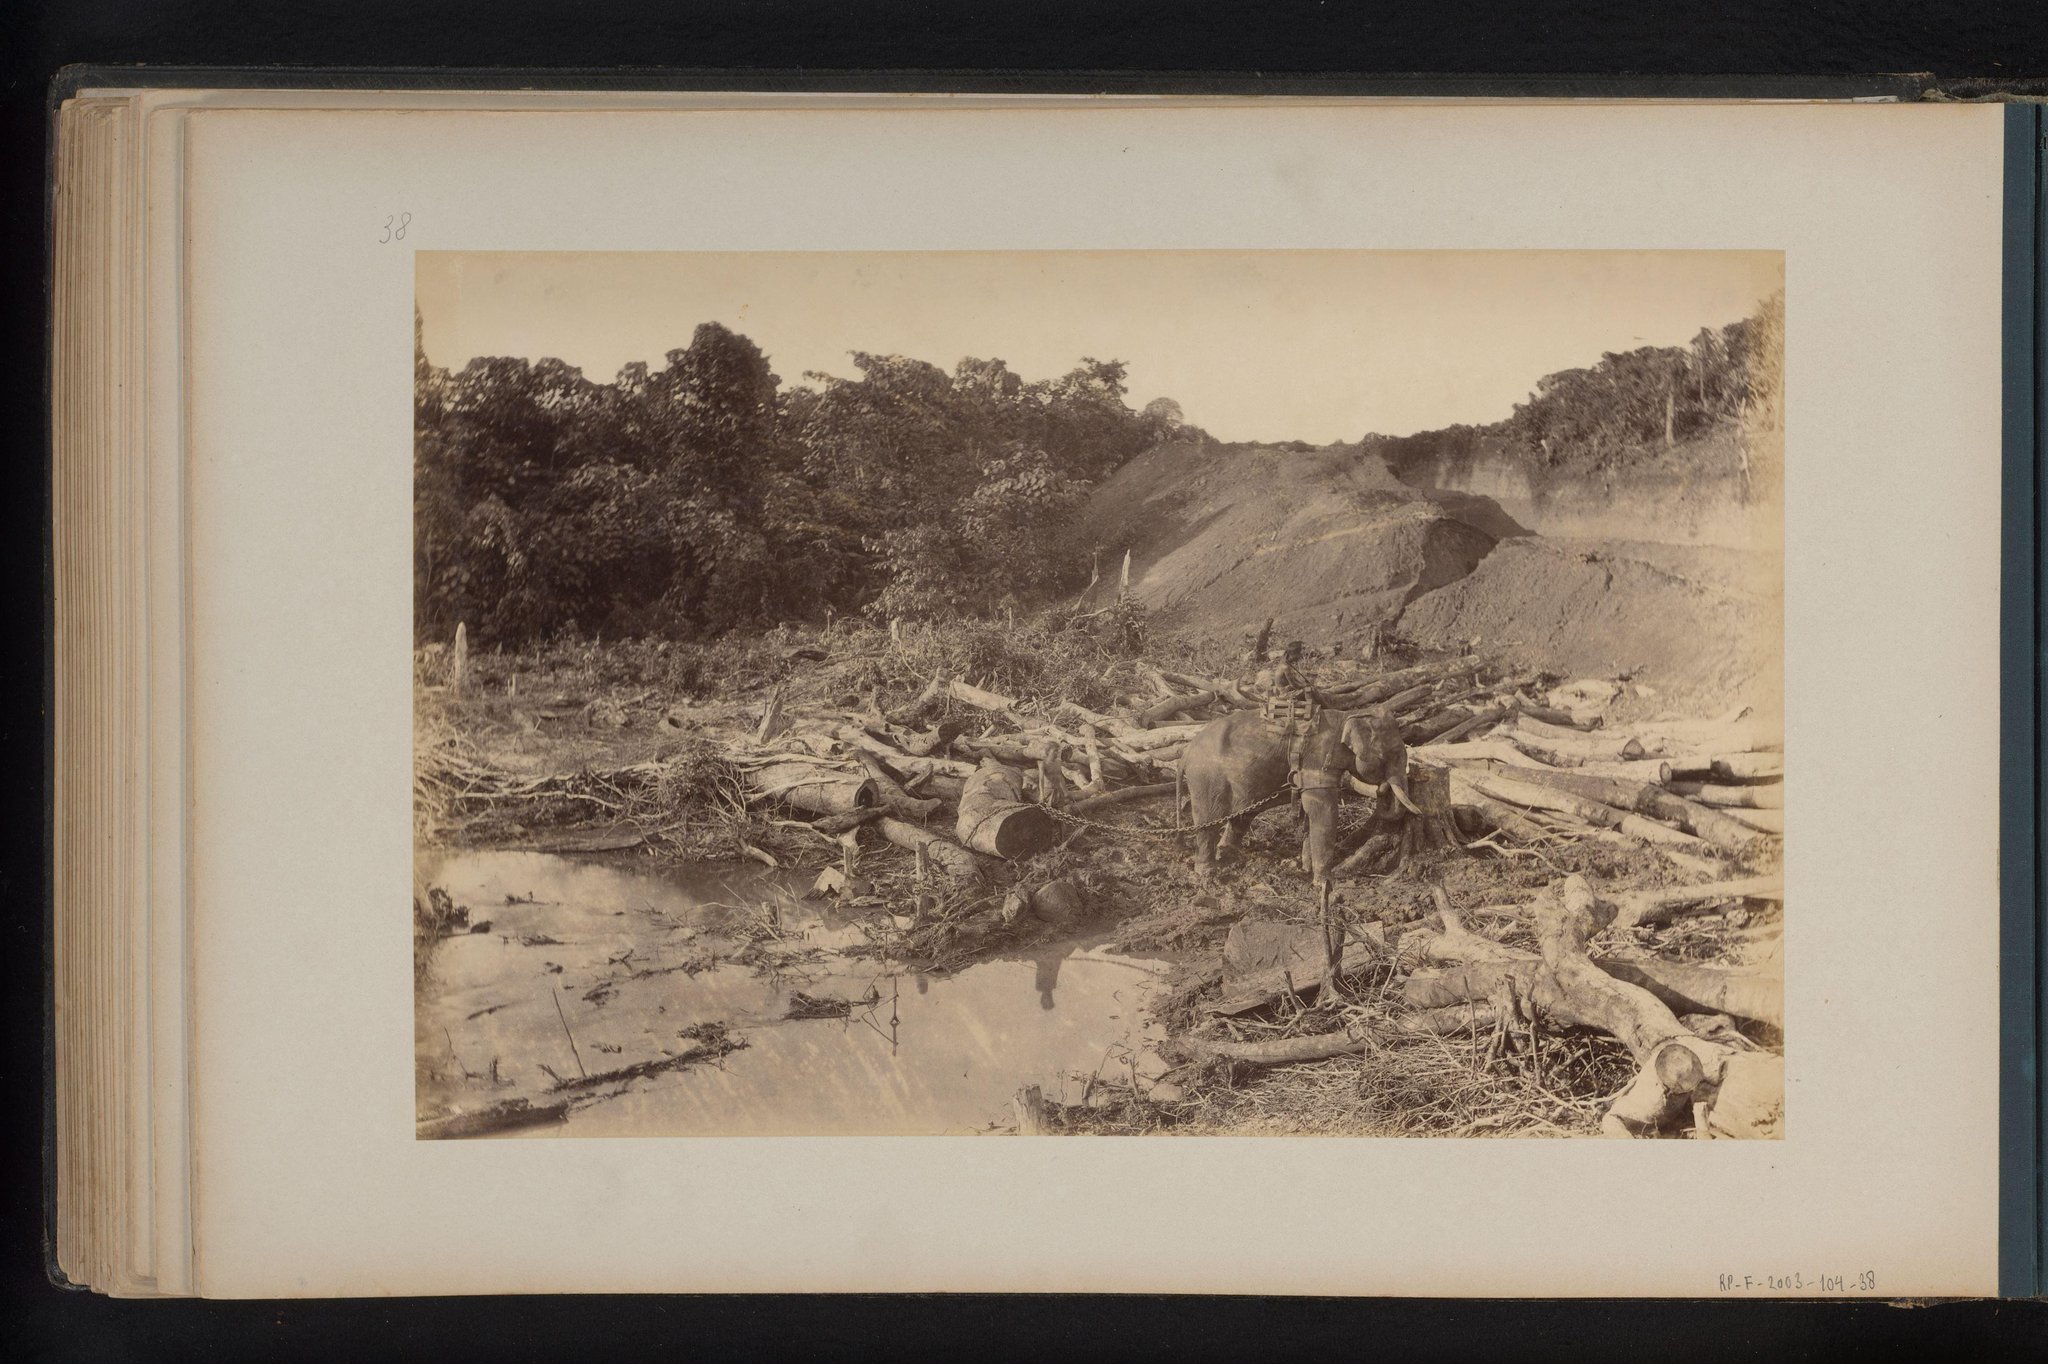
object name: album leaf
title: Arbeider op een olifant versleept boomstammen in een stuk gekapt oerwoud in Lau-Boentoe, Sumatra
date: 1890-1900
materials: cardboard, photographic support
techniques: albumen print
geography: sumatra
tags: woodcutting, woodcutter ~ forestry, jungle, trunked animals: elephant, sumatra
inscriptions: number: ‘38’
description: In de lijst van afbeeldingen wordt deze foto beschreven met de woorden "Elephanten auf Lau-Boentoe -Estate".